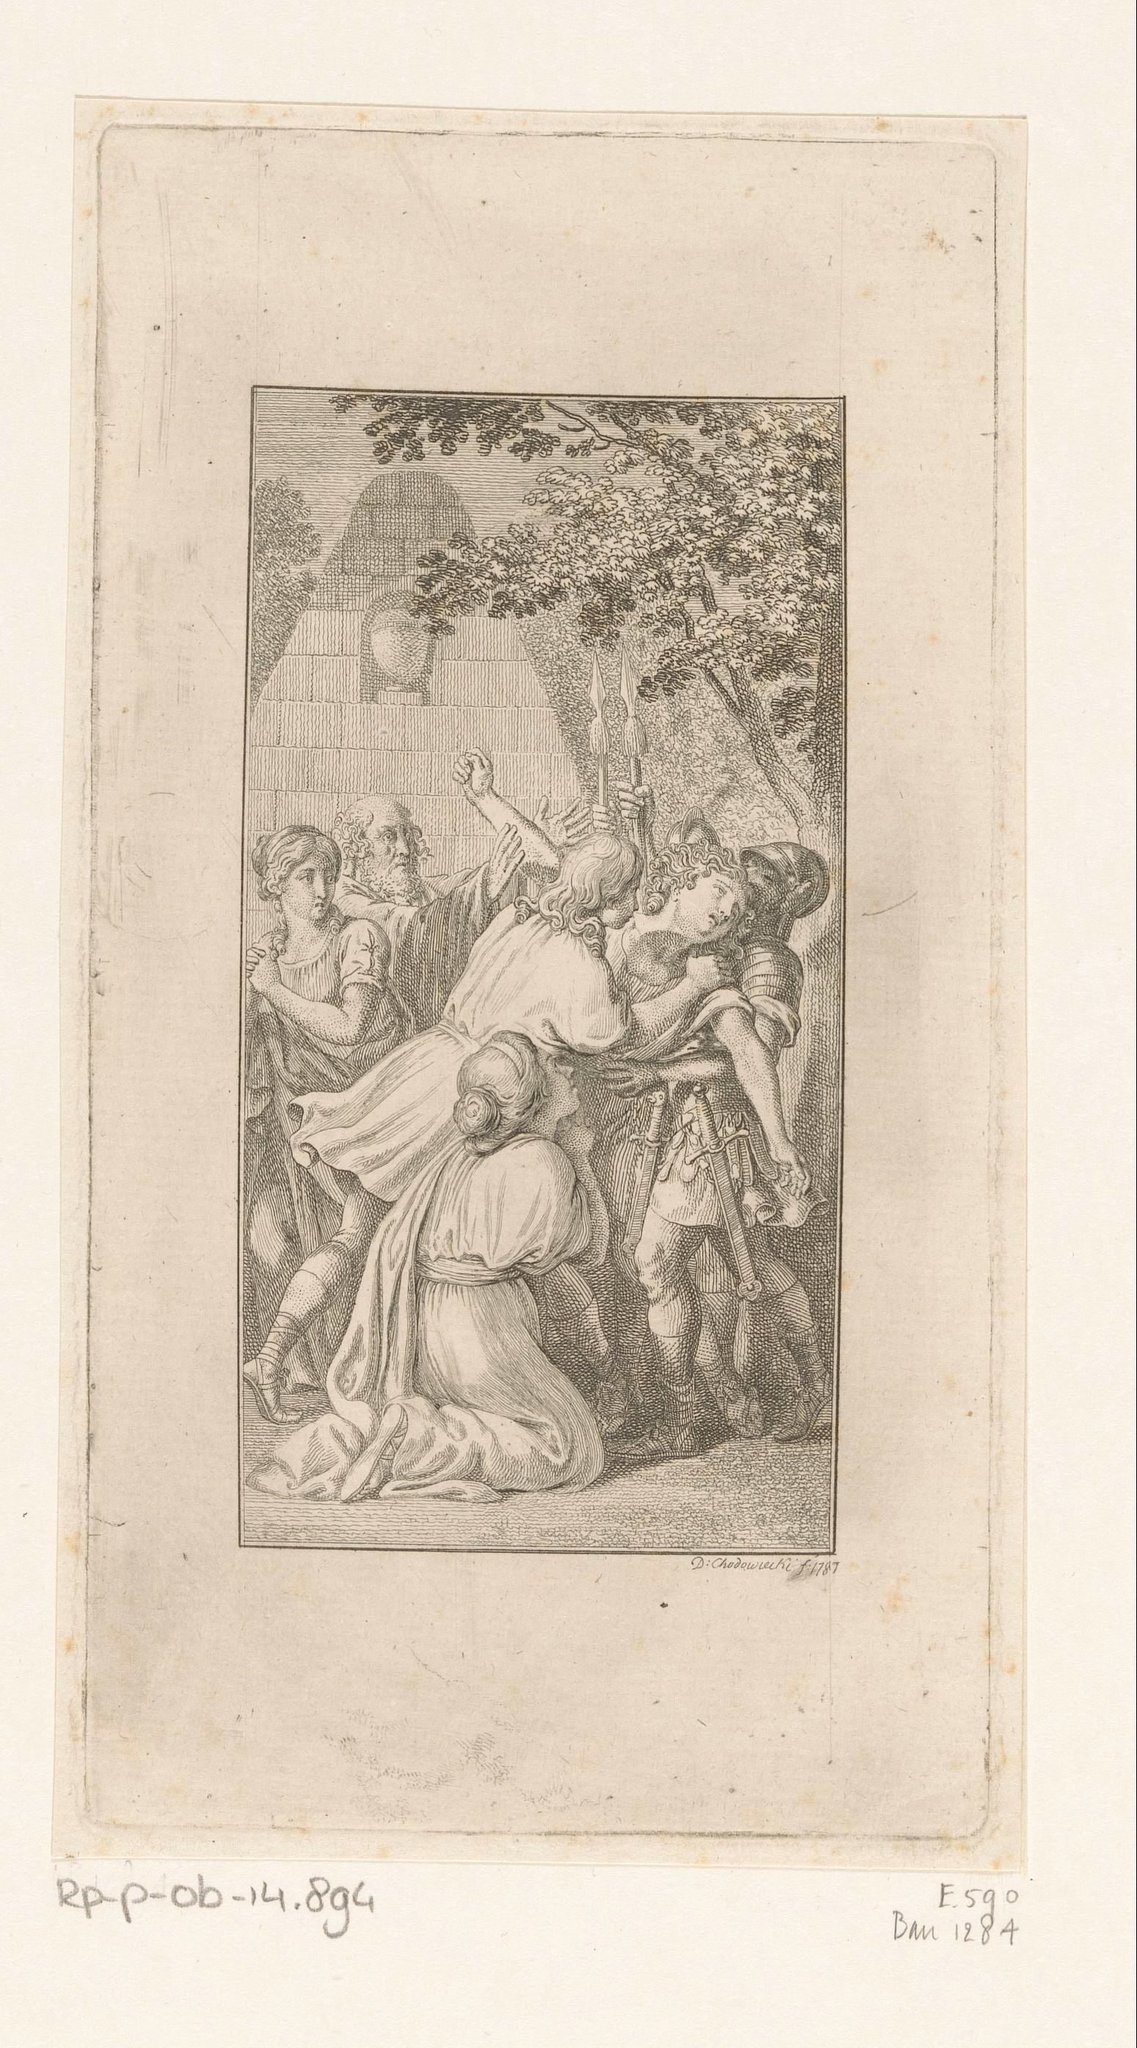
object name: print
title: Orest valt in de handen van een soldaat als Pylades hem arresteert. Elektra zit smekend naast hen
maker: daniel nikolaus chodowiecki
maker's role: draughtsman, print maker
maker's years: 1726-1801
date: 1787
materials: paper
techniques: etching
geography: berlin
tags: literature, the meeting of orestes with electra at agamemnon's tomb, grave-building, monumental tomb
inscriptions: collector's mark: Lugt 2228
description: Vervaardigd voor Gotter's vertelling 'Elektra; ein Trauerspiel'. Prent uit: Gedichte von Friedrich Wilhelm Gotter. Gotha bei Carl: Wilhelm Ettinger, 1788, dl. 2.